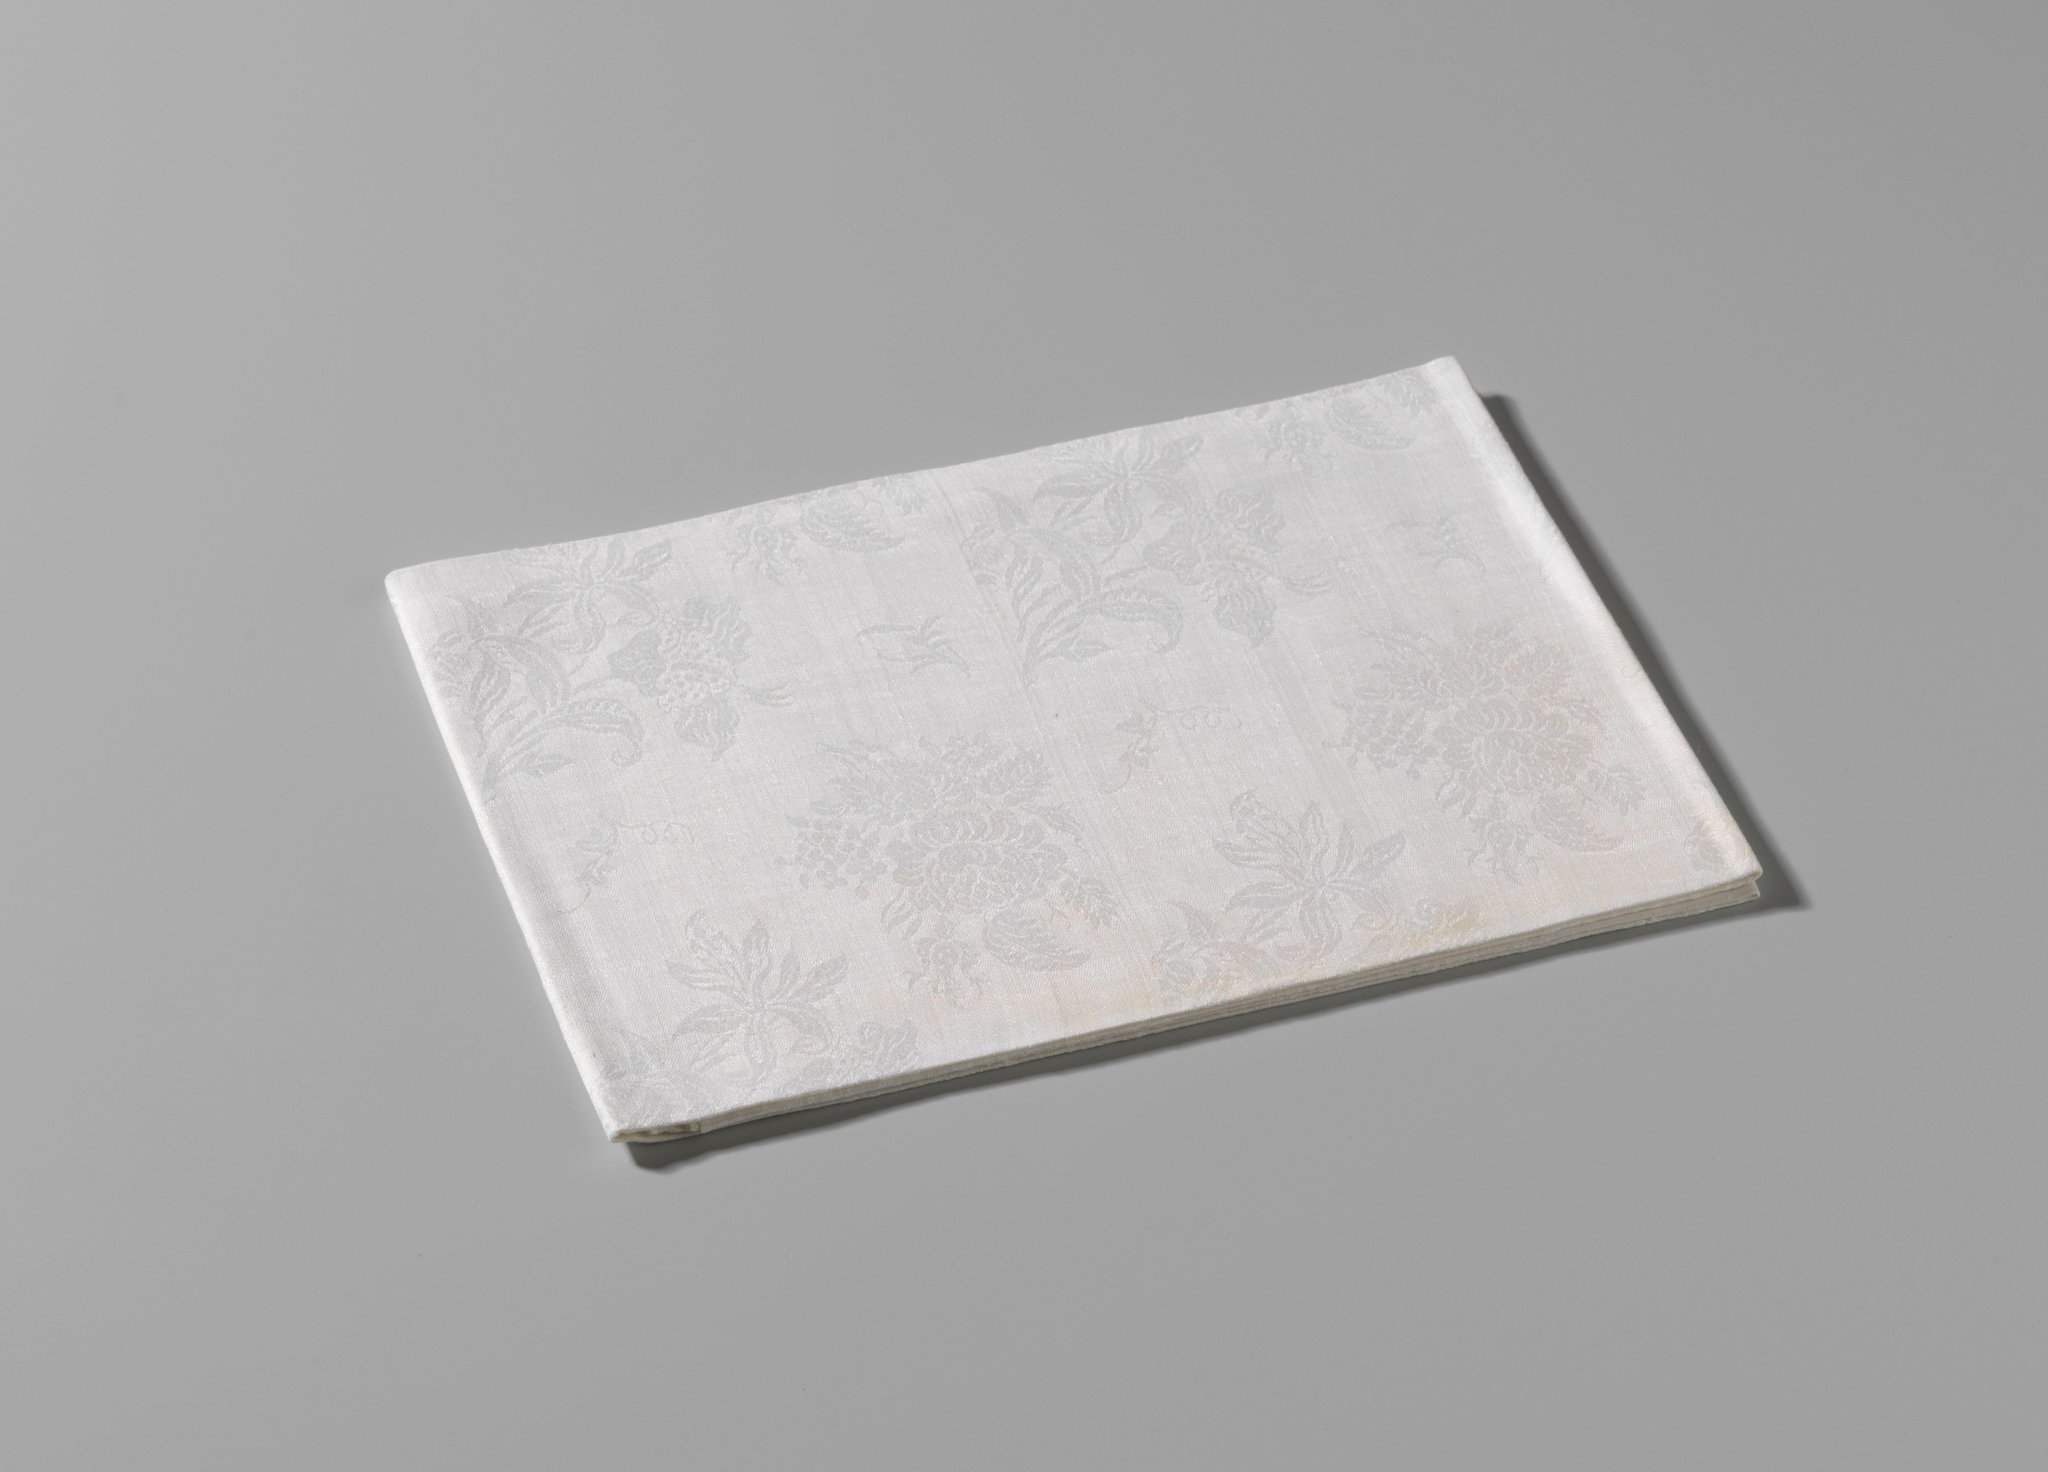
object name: napkin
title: Servet met bloemboeketten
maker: Anonymous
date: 1700-1899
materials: linen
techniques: damask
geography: saxony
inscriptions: : ‘24’, mark: ‘GvO’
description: Servet van linnendamast met bloemboeketten. Middenveld: Bloempatroon van verspringende rijen met twee soorten bloemboeketten. Staande en liggende randen: een bloemslinger, de hoeken een bloemboeket.